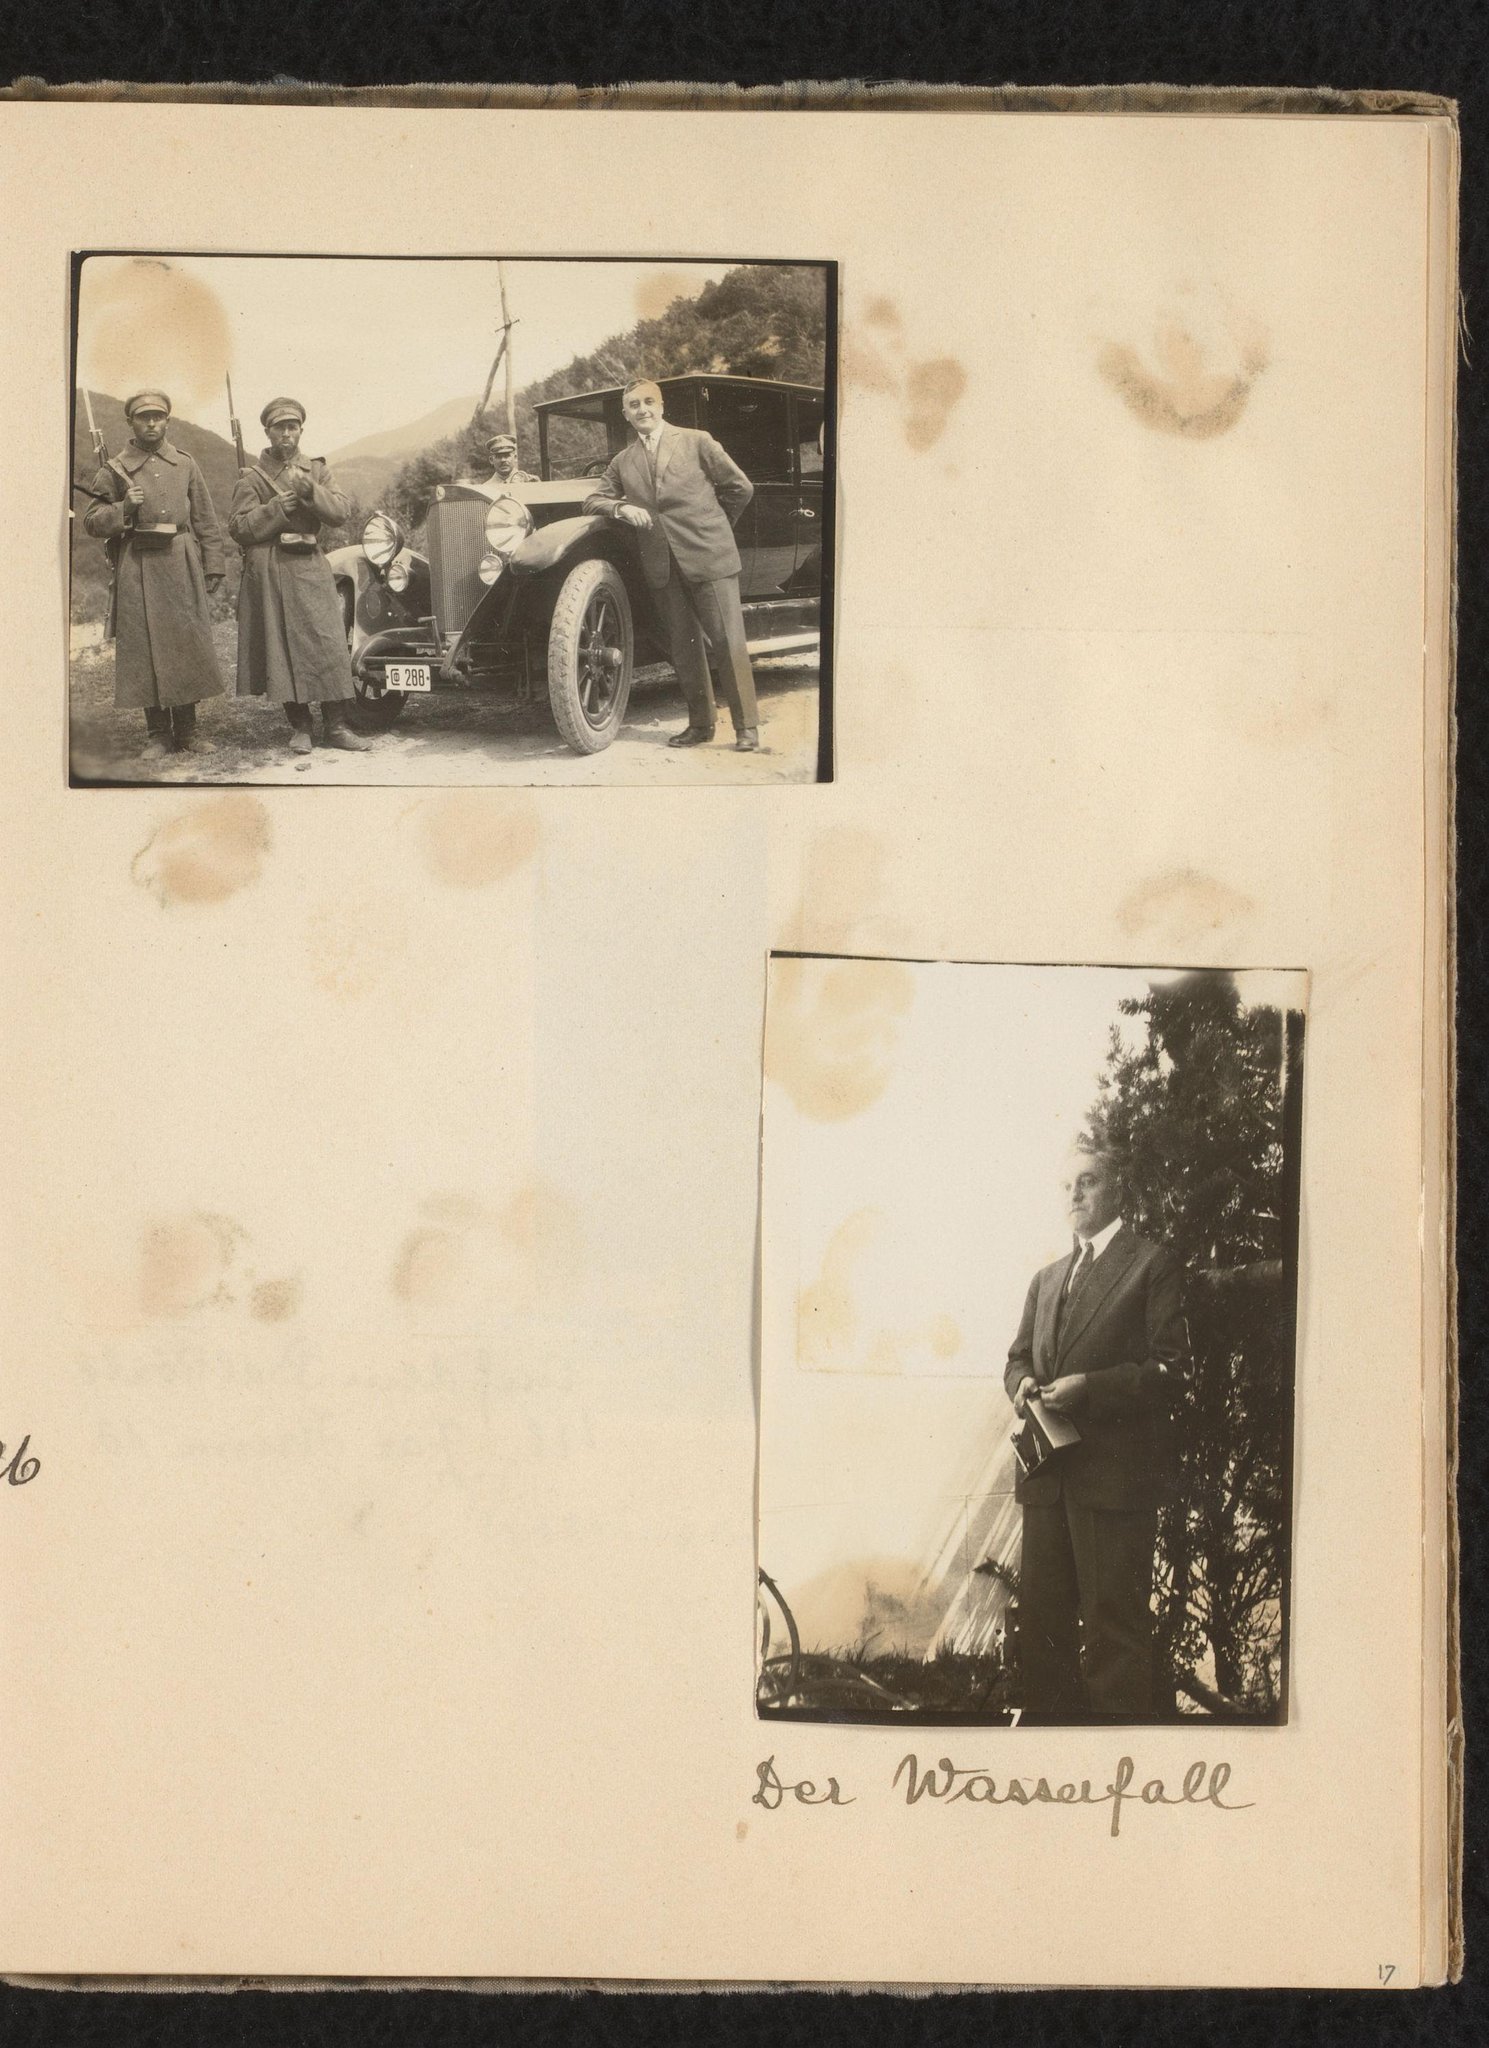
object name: photograph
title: Eugen Wachenheimer poseert met bij een auto met twee soldaten en bij de watervallen van Kostenets, 1926, Bulgarije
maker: else wachenheimer-moos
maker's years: 1895-1944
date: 1926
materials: paper, photographic support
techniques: gelatin silver print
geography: bulgaria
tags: eugen wachenheimer, military service, the family travelling, on holiday, waterfall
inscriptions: inscription: ‘[19]26 Der Wasserfall’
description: Blad bevat twee foto's van Eugen Wachenheimer (in kostuum). Onderdeel van het fotoalbum van de reizen die Eugen en Else Wachenheimer jaarlijks maakten rondom de viering van hun huwelijksdag en verloving.